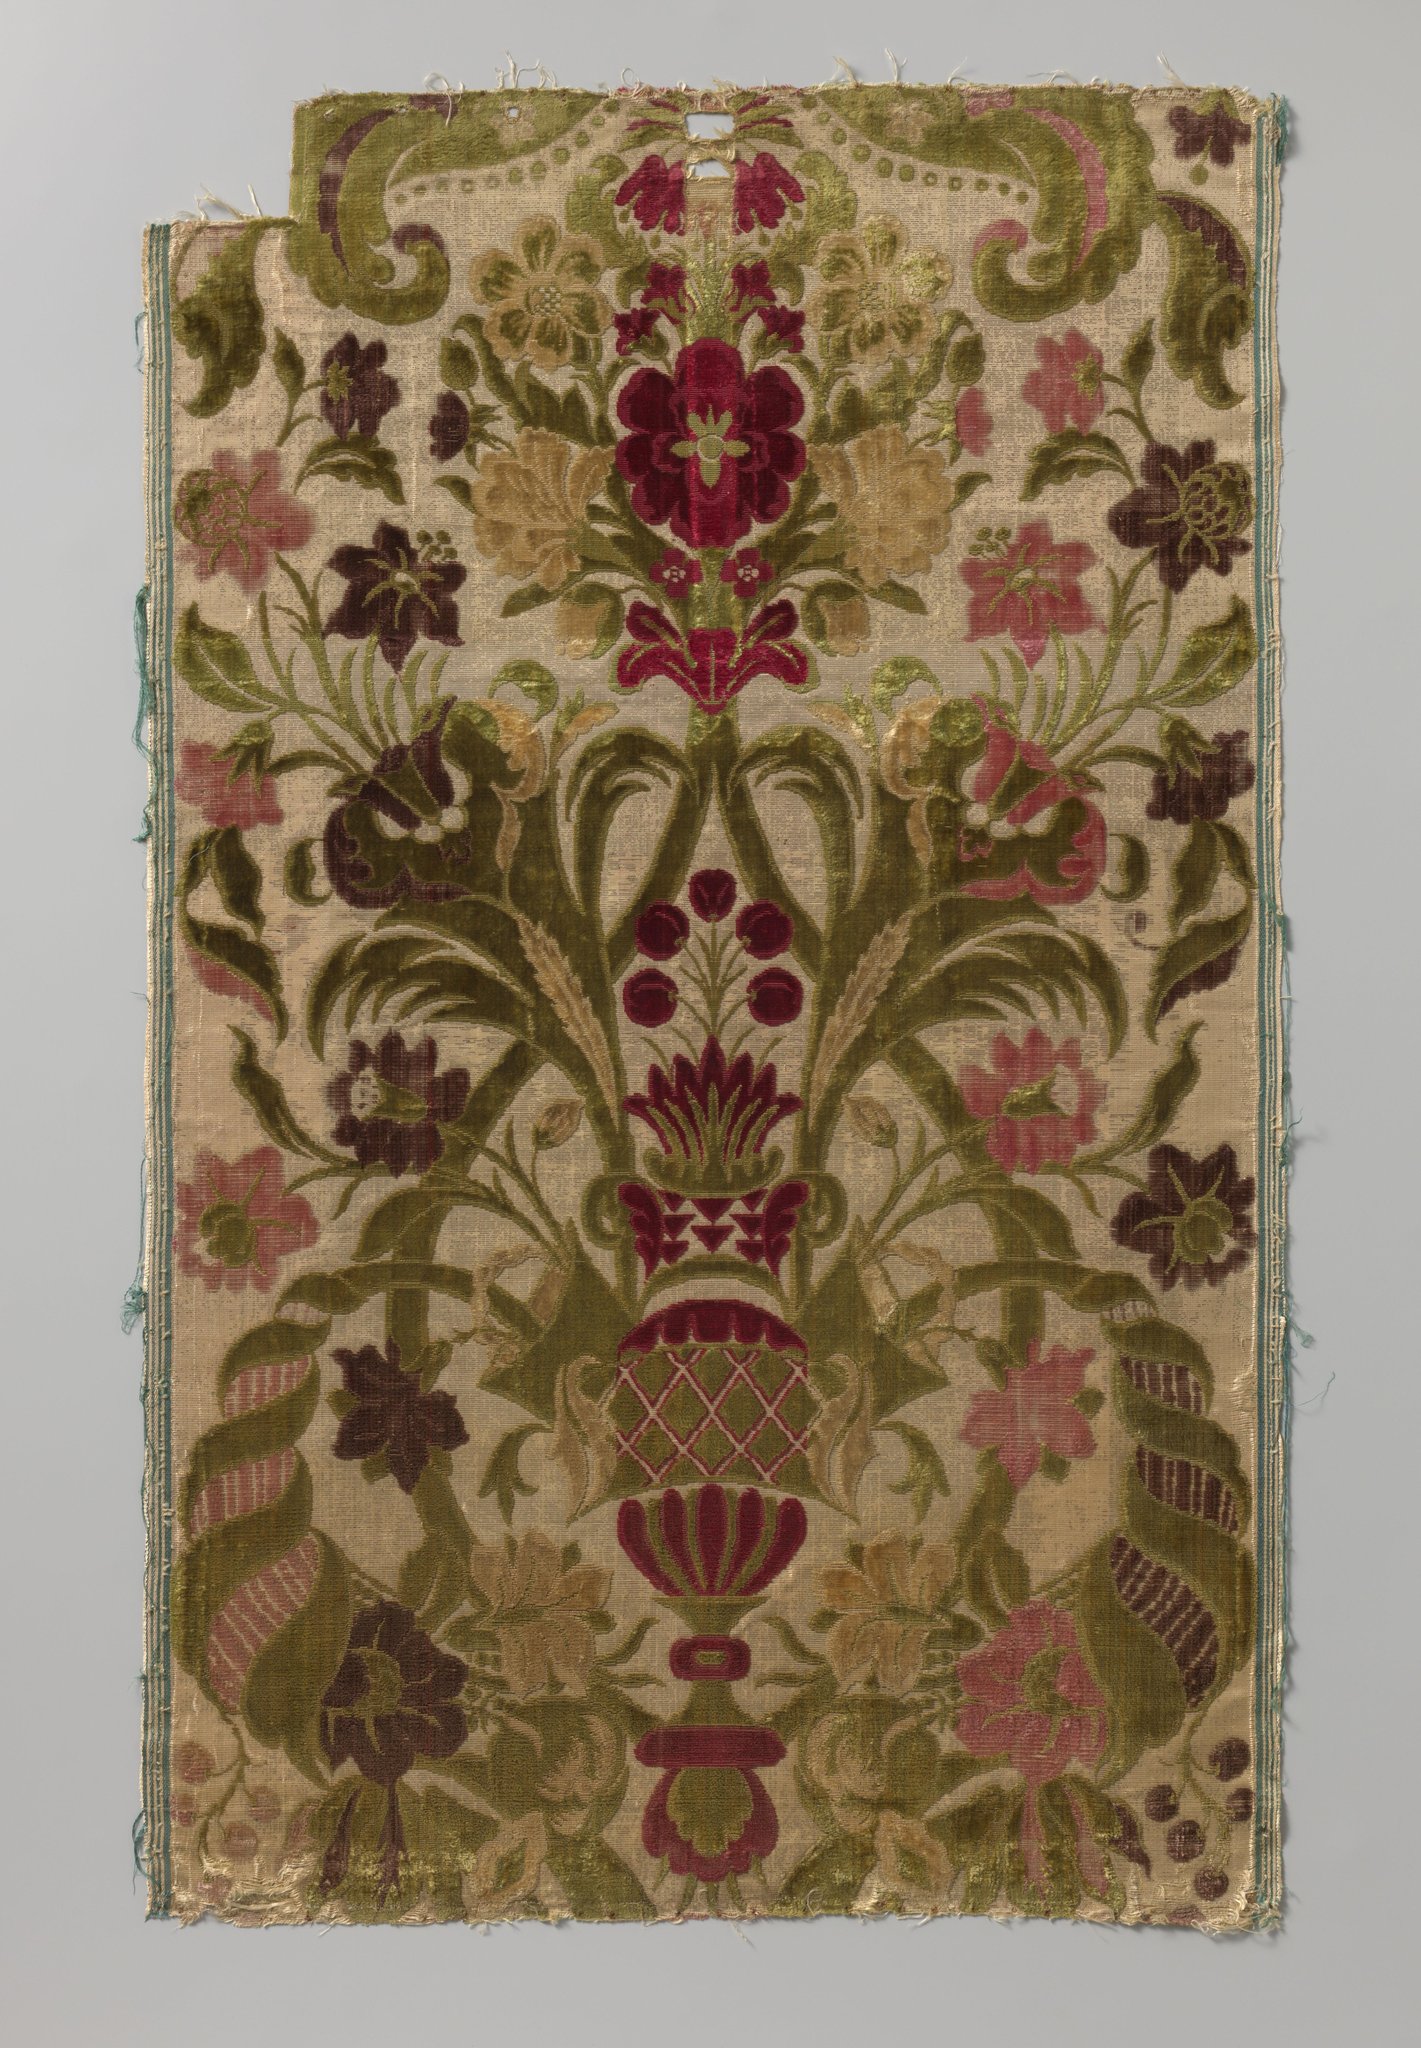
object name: fragment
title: Baan van veelkleurig ciseléfluweel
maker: Anonymous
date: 1675-1699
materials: silk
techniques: velvet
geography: genoa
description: Baan veelkleurig zijdefluweel met ongeschoren pool. Symmetrisch patroon van een vaas in ojiefvorm met bloem- en bladranken en twee hoorns van overvloed. Boven de vaas een rozet met bloemen en acanthusranken. Kleuren: groen, roze, rood, wijnrood en brons.